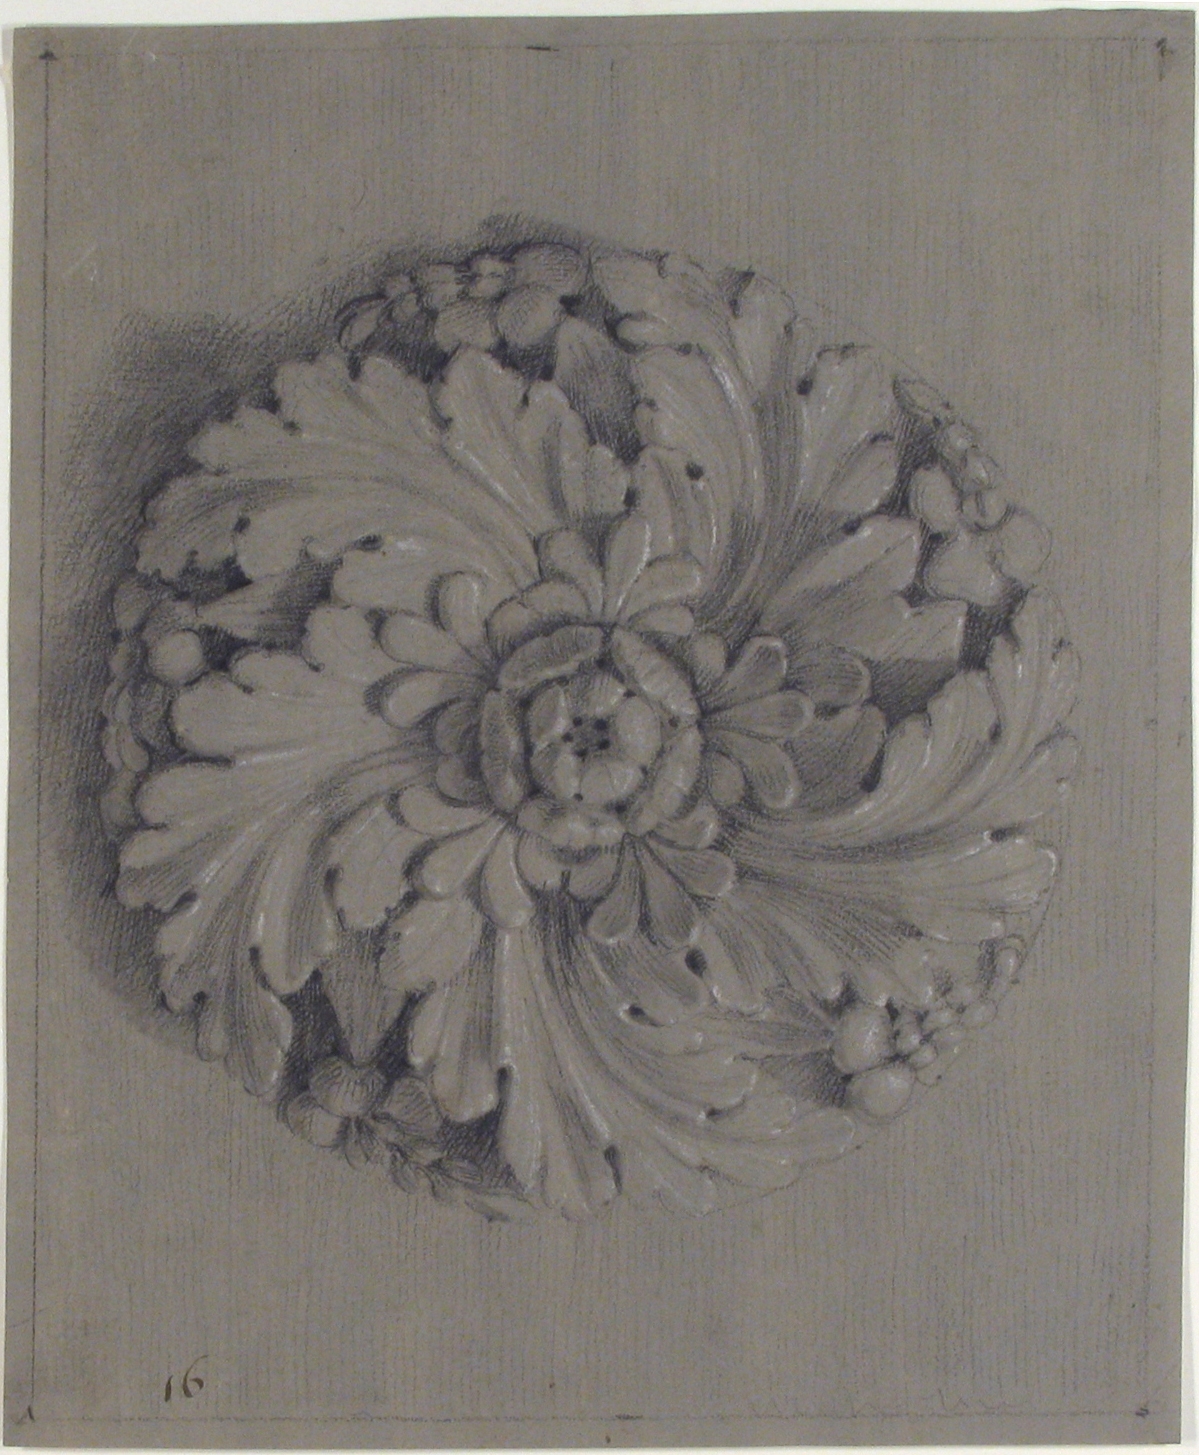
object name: drawing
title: Design for a Rosette Relief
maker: anonymous, french, 19th century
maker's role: artist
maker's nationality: french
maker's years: 1800-1900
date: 1825-1850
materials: chalk, graphite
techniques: heightening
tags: leaves